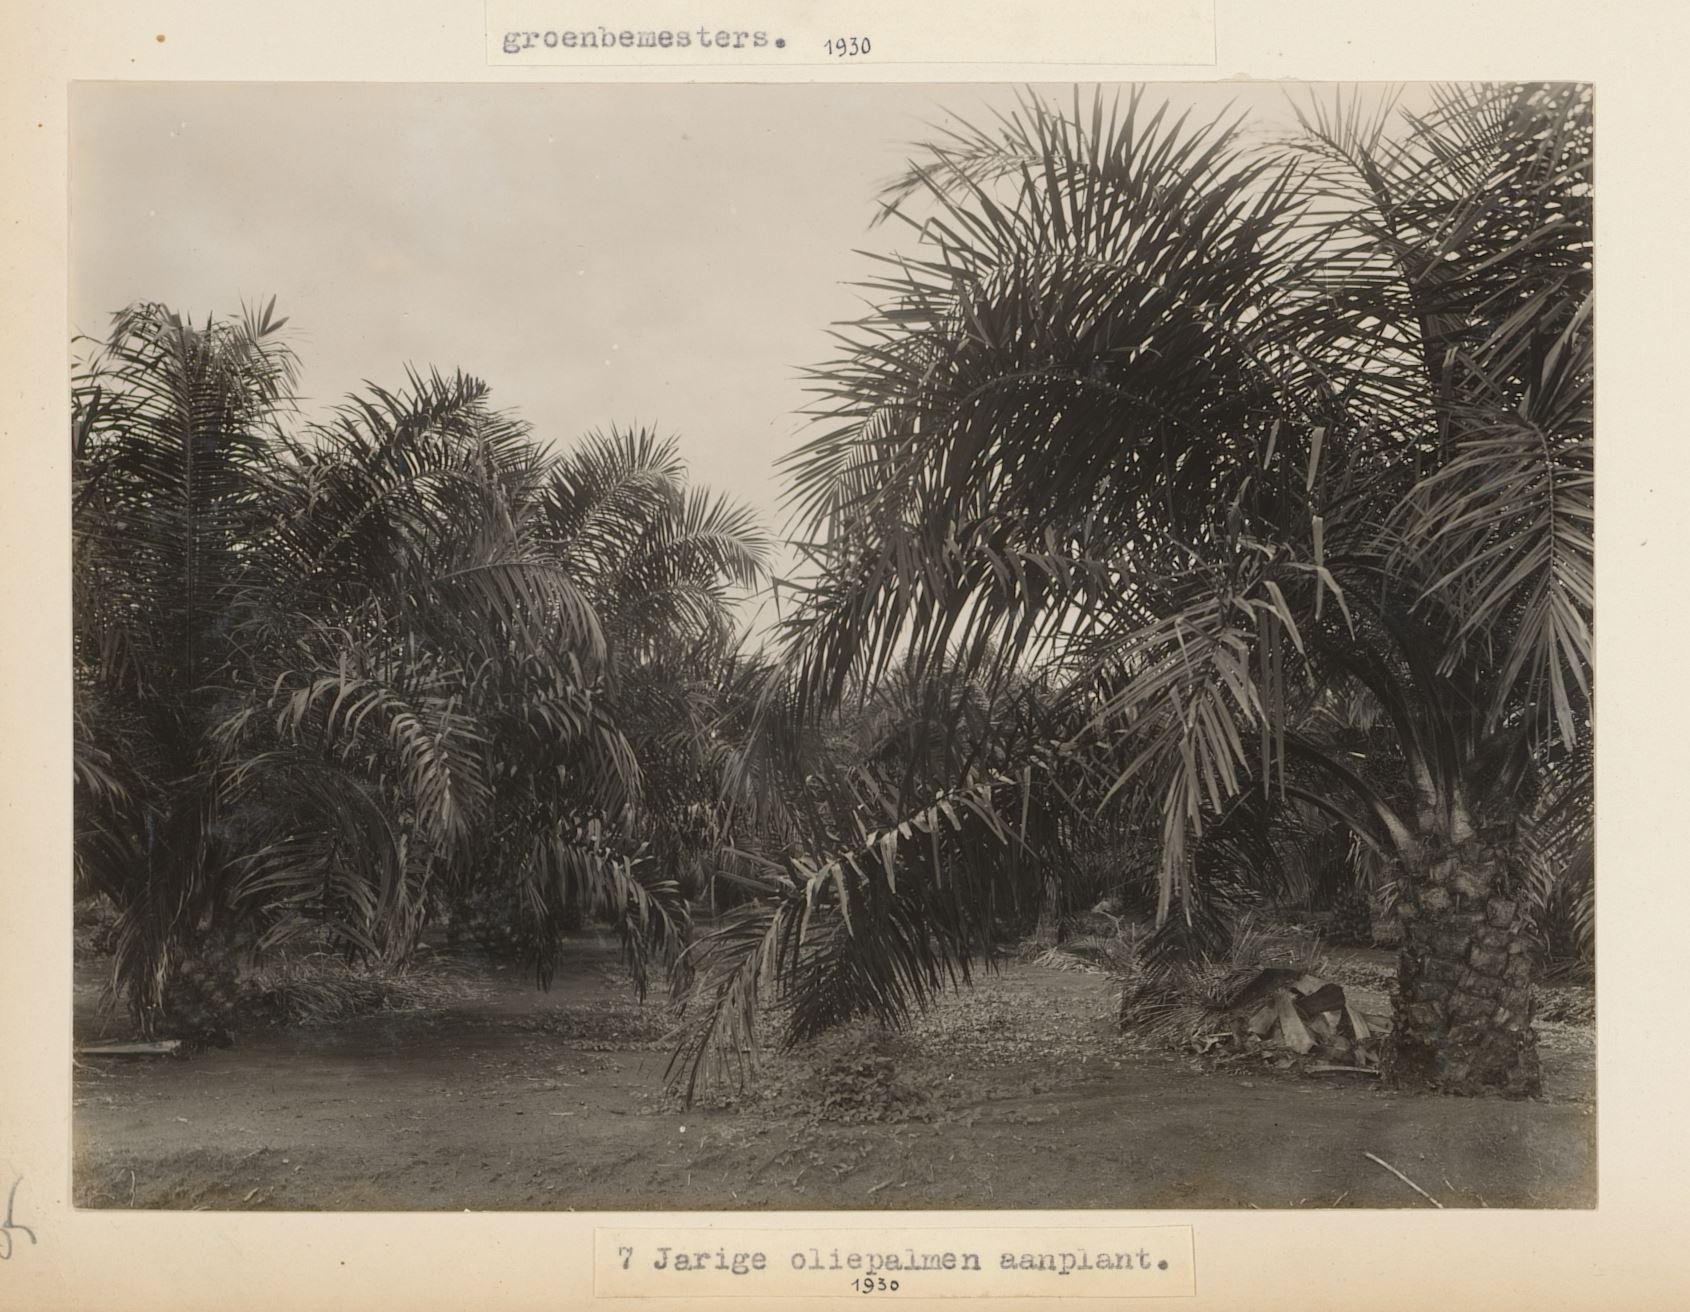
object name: photograph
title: 7 Jarige oliepalmen aanplant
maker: Anonymous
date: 1930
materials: photographic support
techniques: gelatin silver print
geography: sumatra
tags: plantation, (non-fruit) products of plants or trees: palm oil, sumatra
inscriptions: inscription: ‘7 Jarige oliepalmen aanplant / 1930’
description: Gezicht op een veld met zevenjarige oliepalmen, 1930. Met etiket met onderschrift. Onderdeel van het fotoalbum over de plantages Brussel en Pernantian van de Sumatra Caoutchouc Maatschappij op de Oostkust van Sumatra in de jaren 1910-1935.